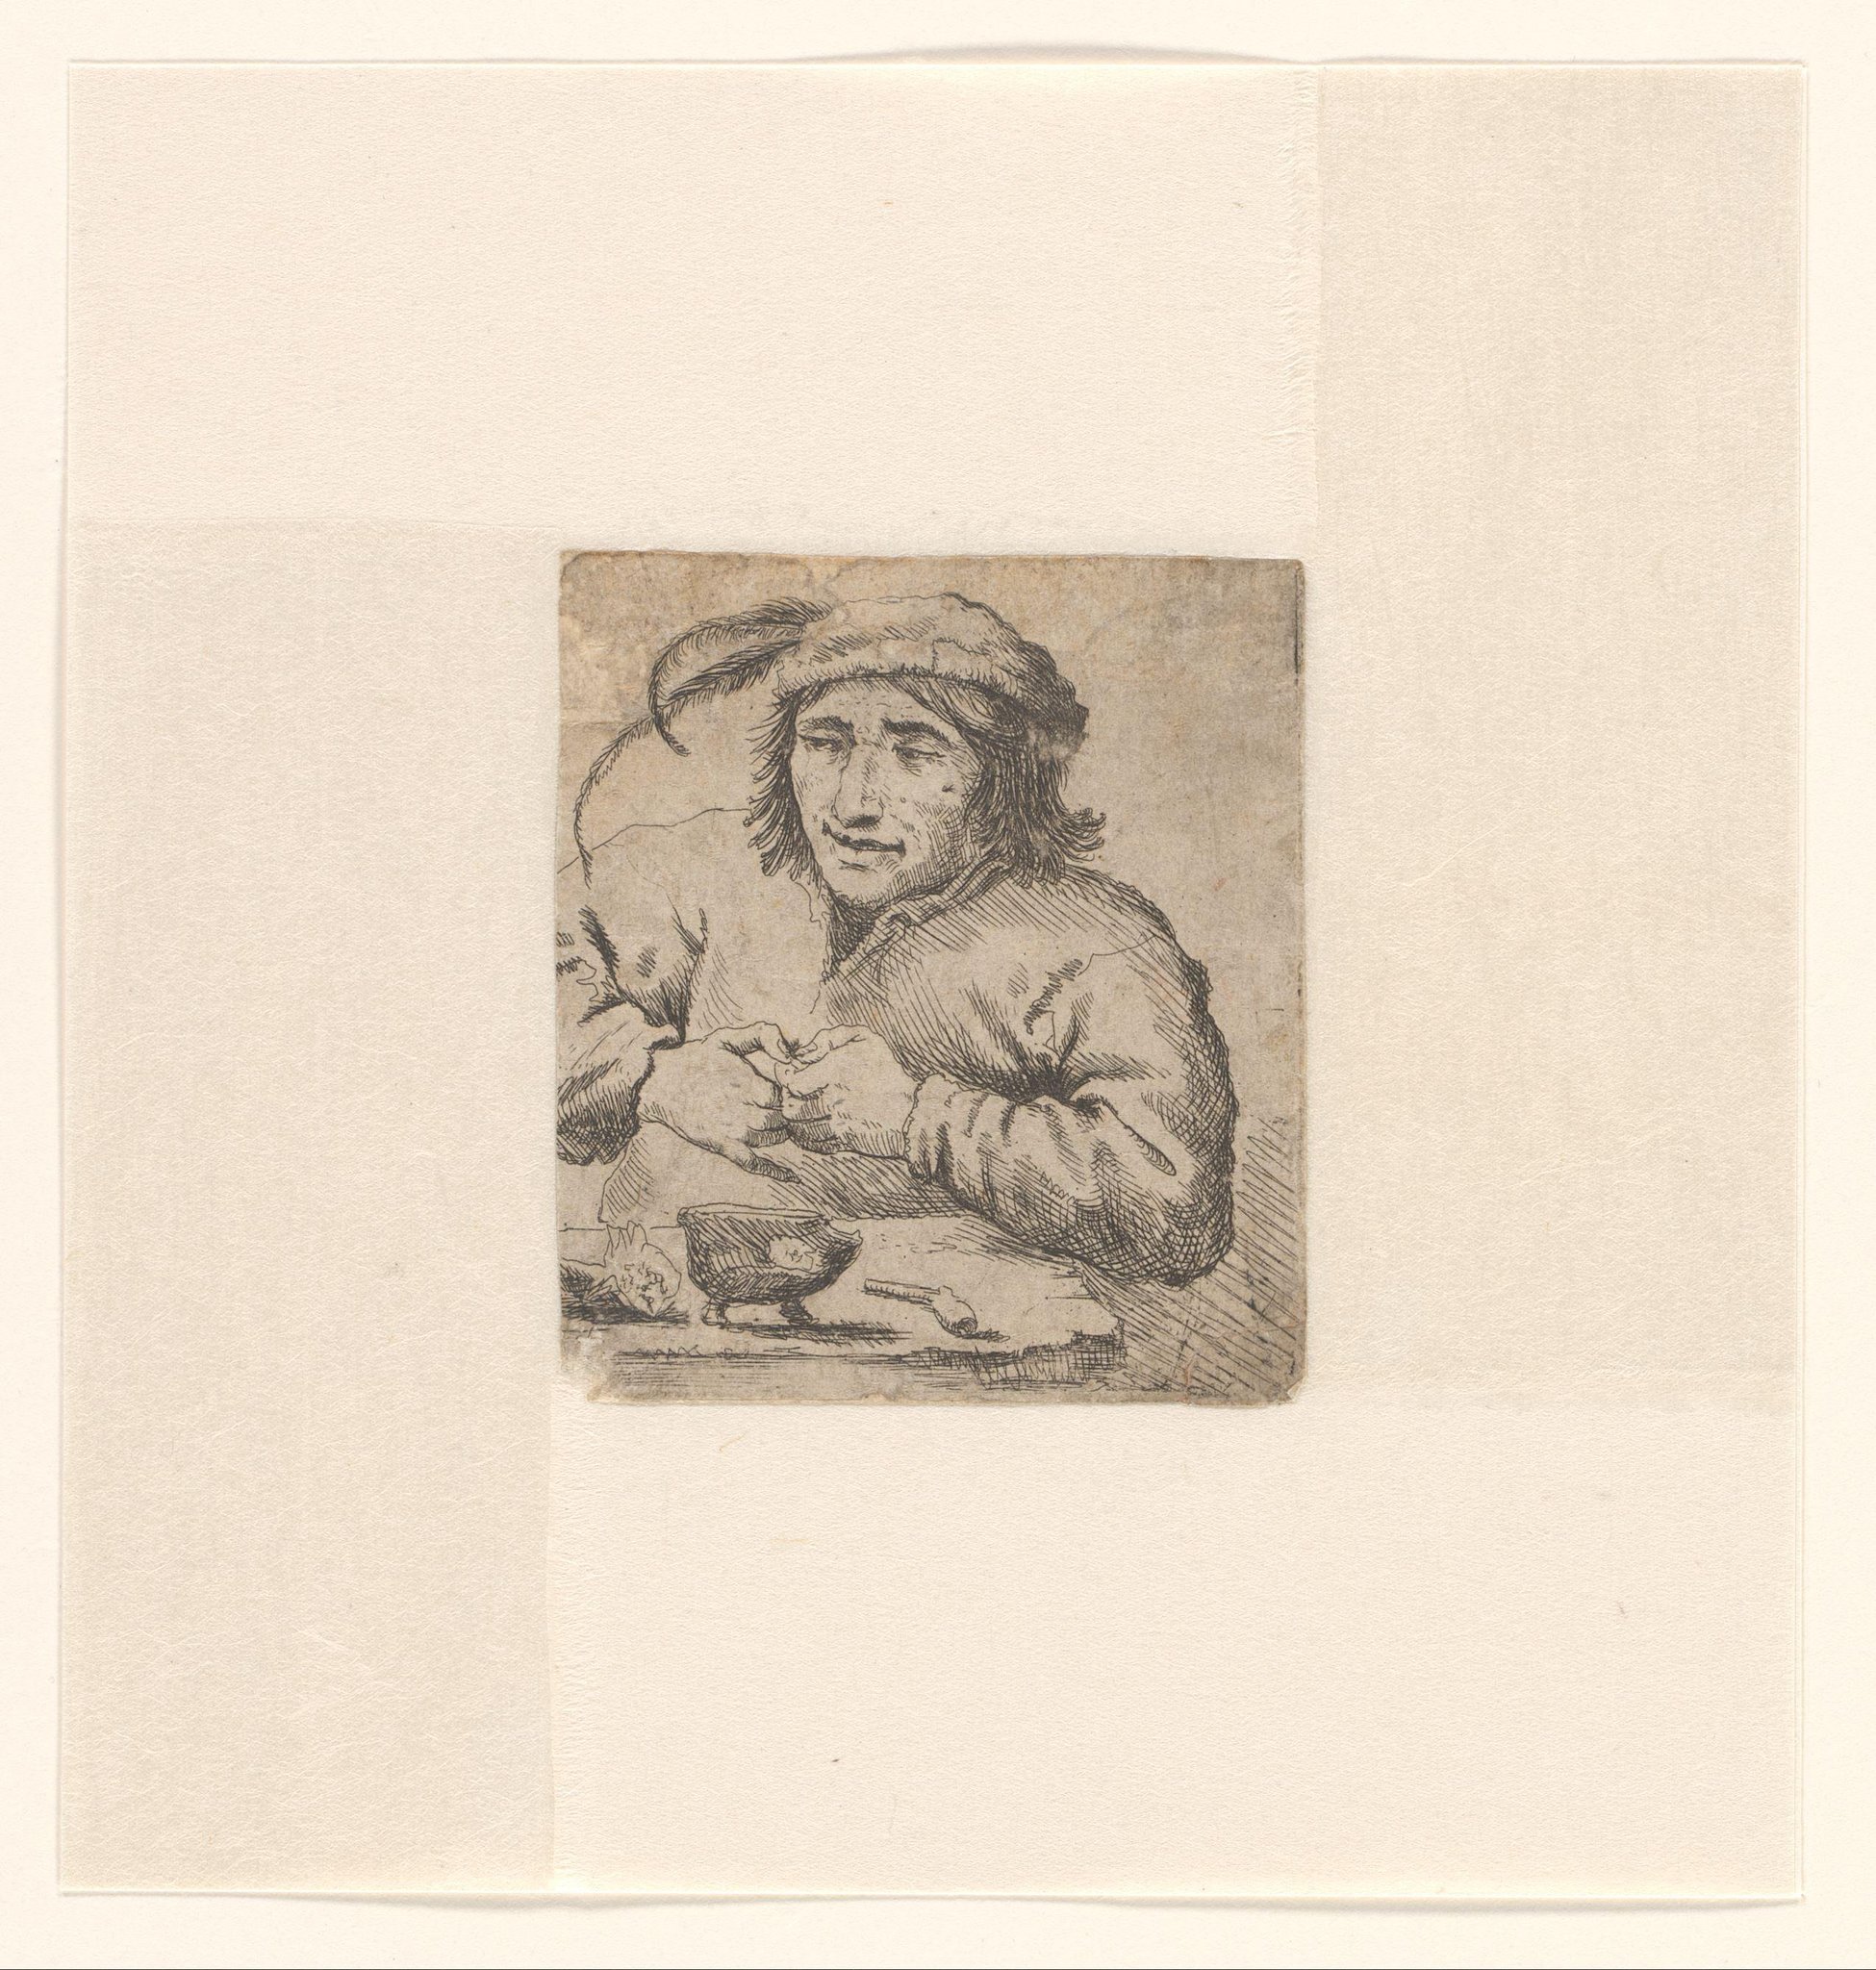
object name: print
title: Man stopt zijn pijp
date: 1622-1688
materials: paper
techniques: etching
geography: southern netherlands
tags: sitting figure, pipe ~ tobacco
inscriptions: collector's mark: Lugt 2228